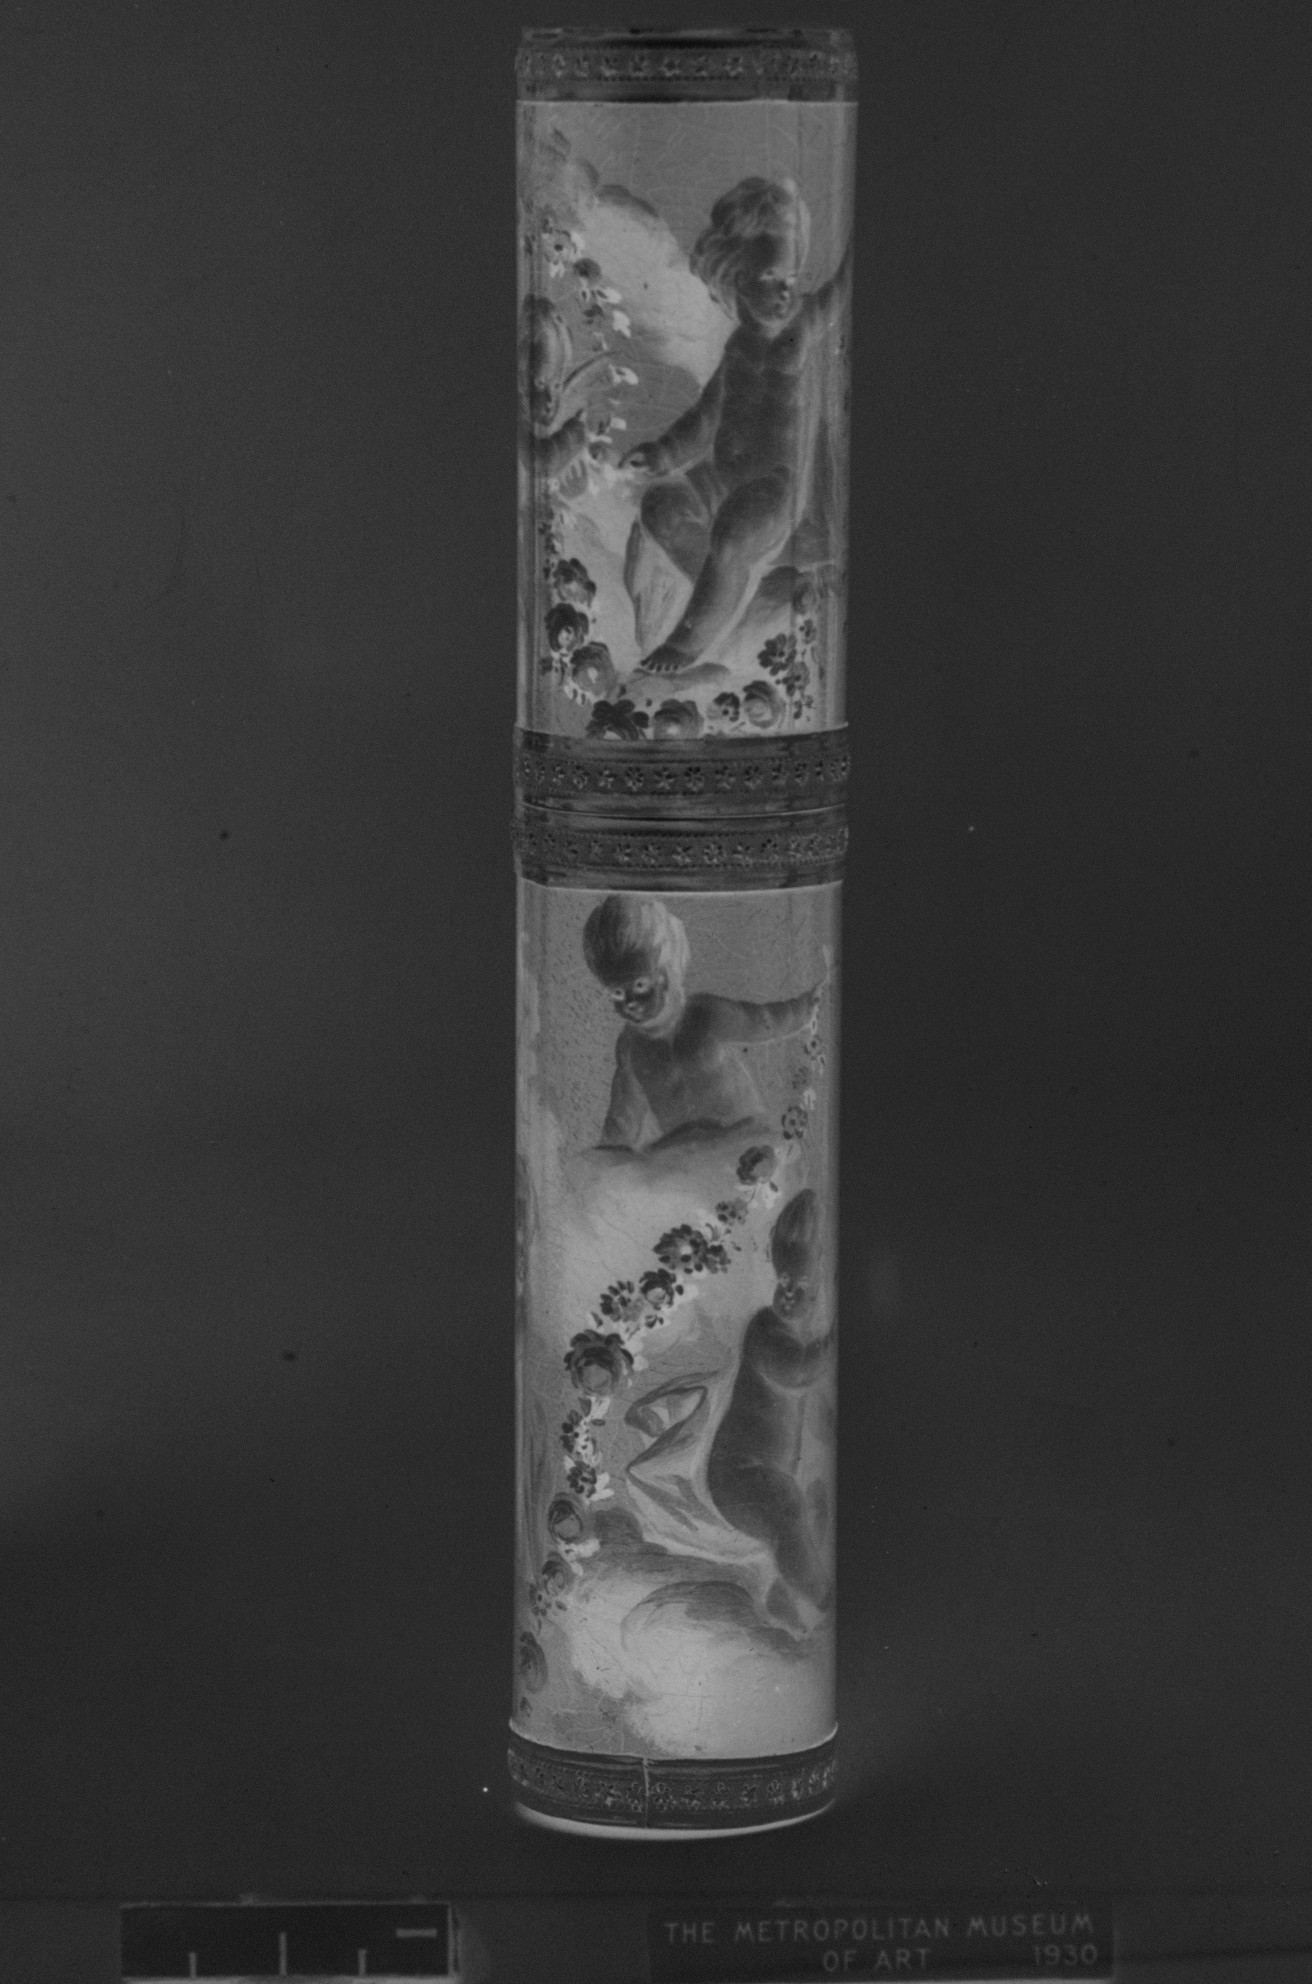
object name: étui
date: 1701-1800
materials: gold, shell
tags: cupid